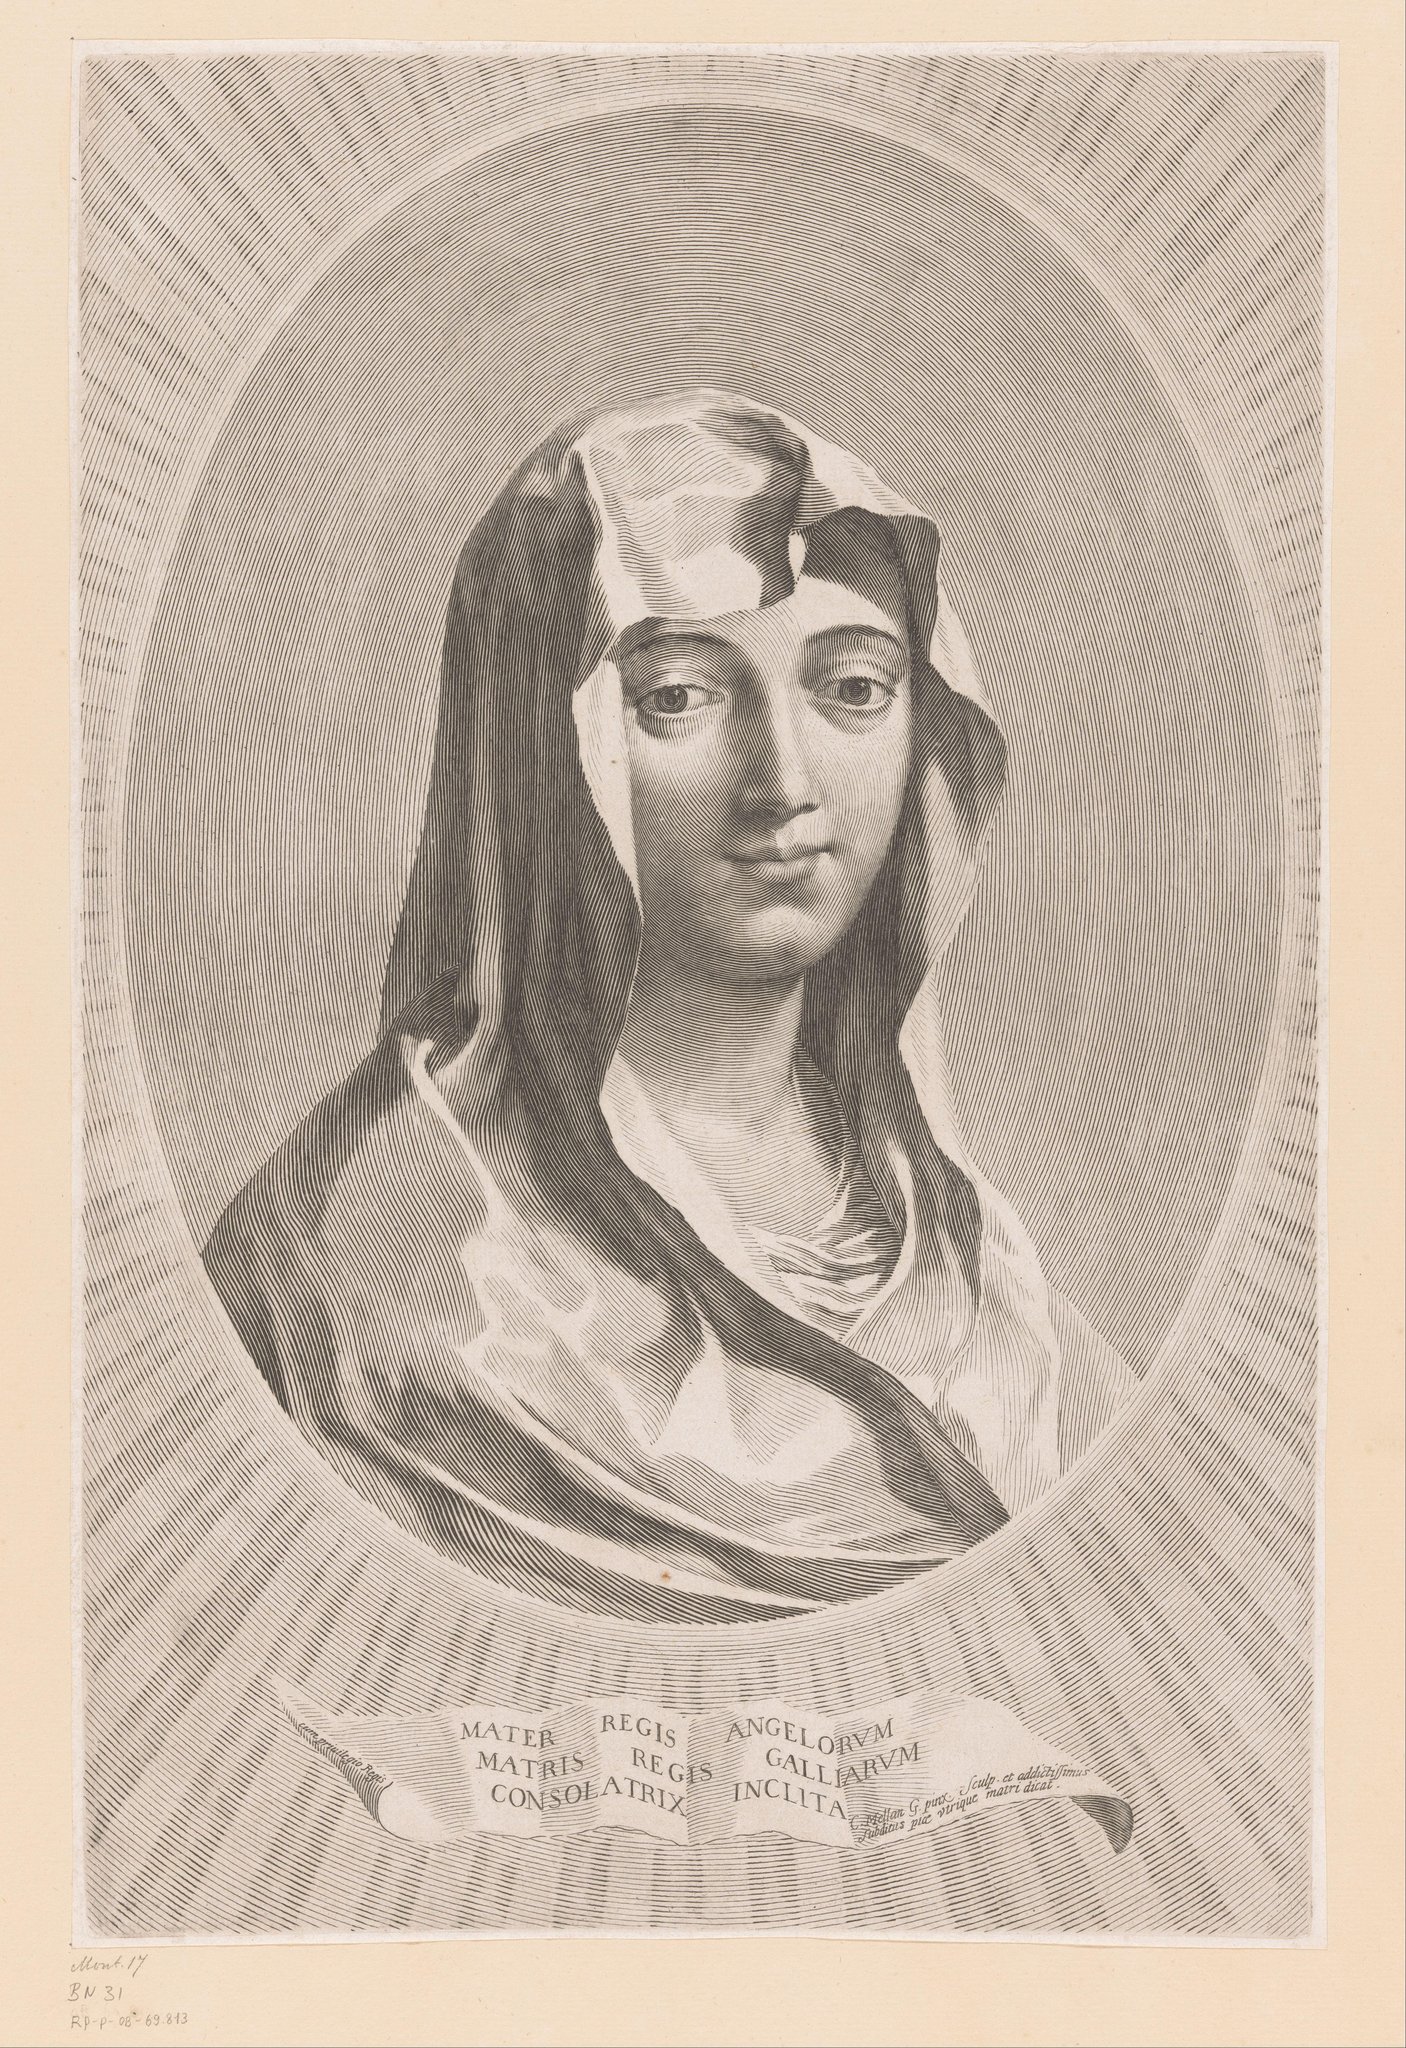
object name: print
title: Maria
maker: claude mellan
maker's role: draughtsman, print maker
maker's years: 1598-1688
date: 1608-1688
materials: paper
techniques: engraving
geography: france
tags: 'portraits' of mary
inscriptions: collector's mark: Lugt 240